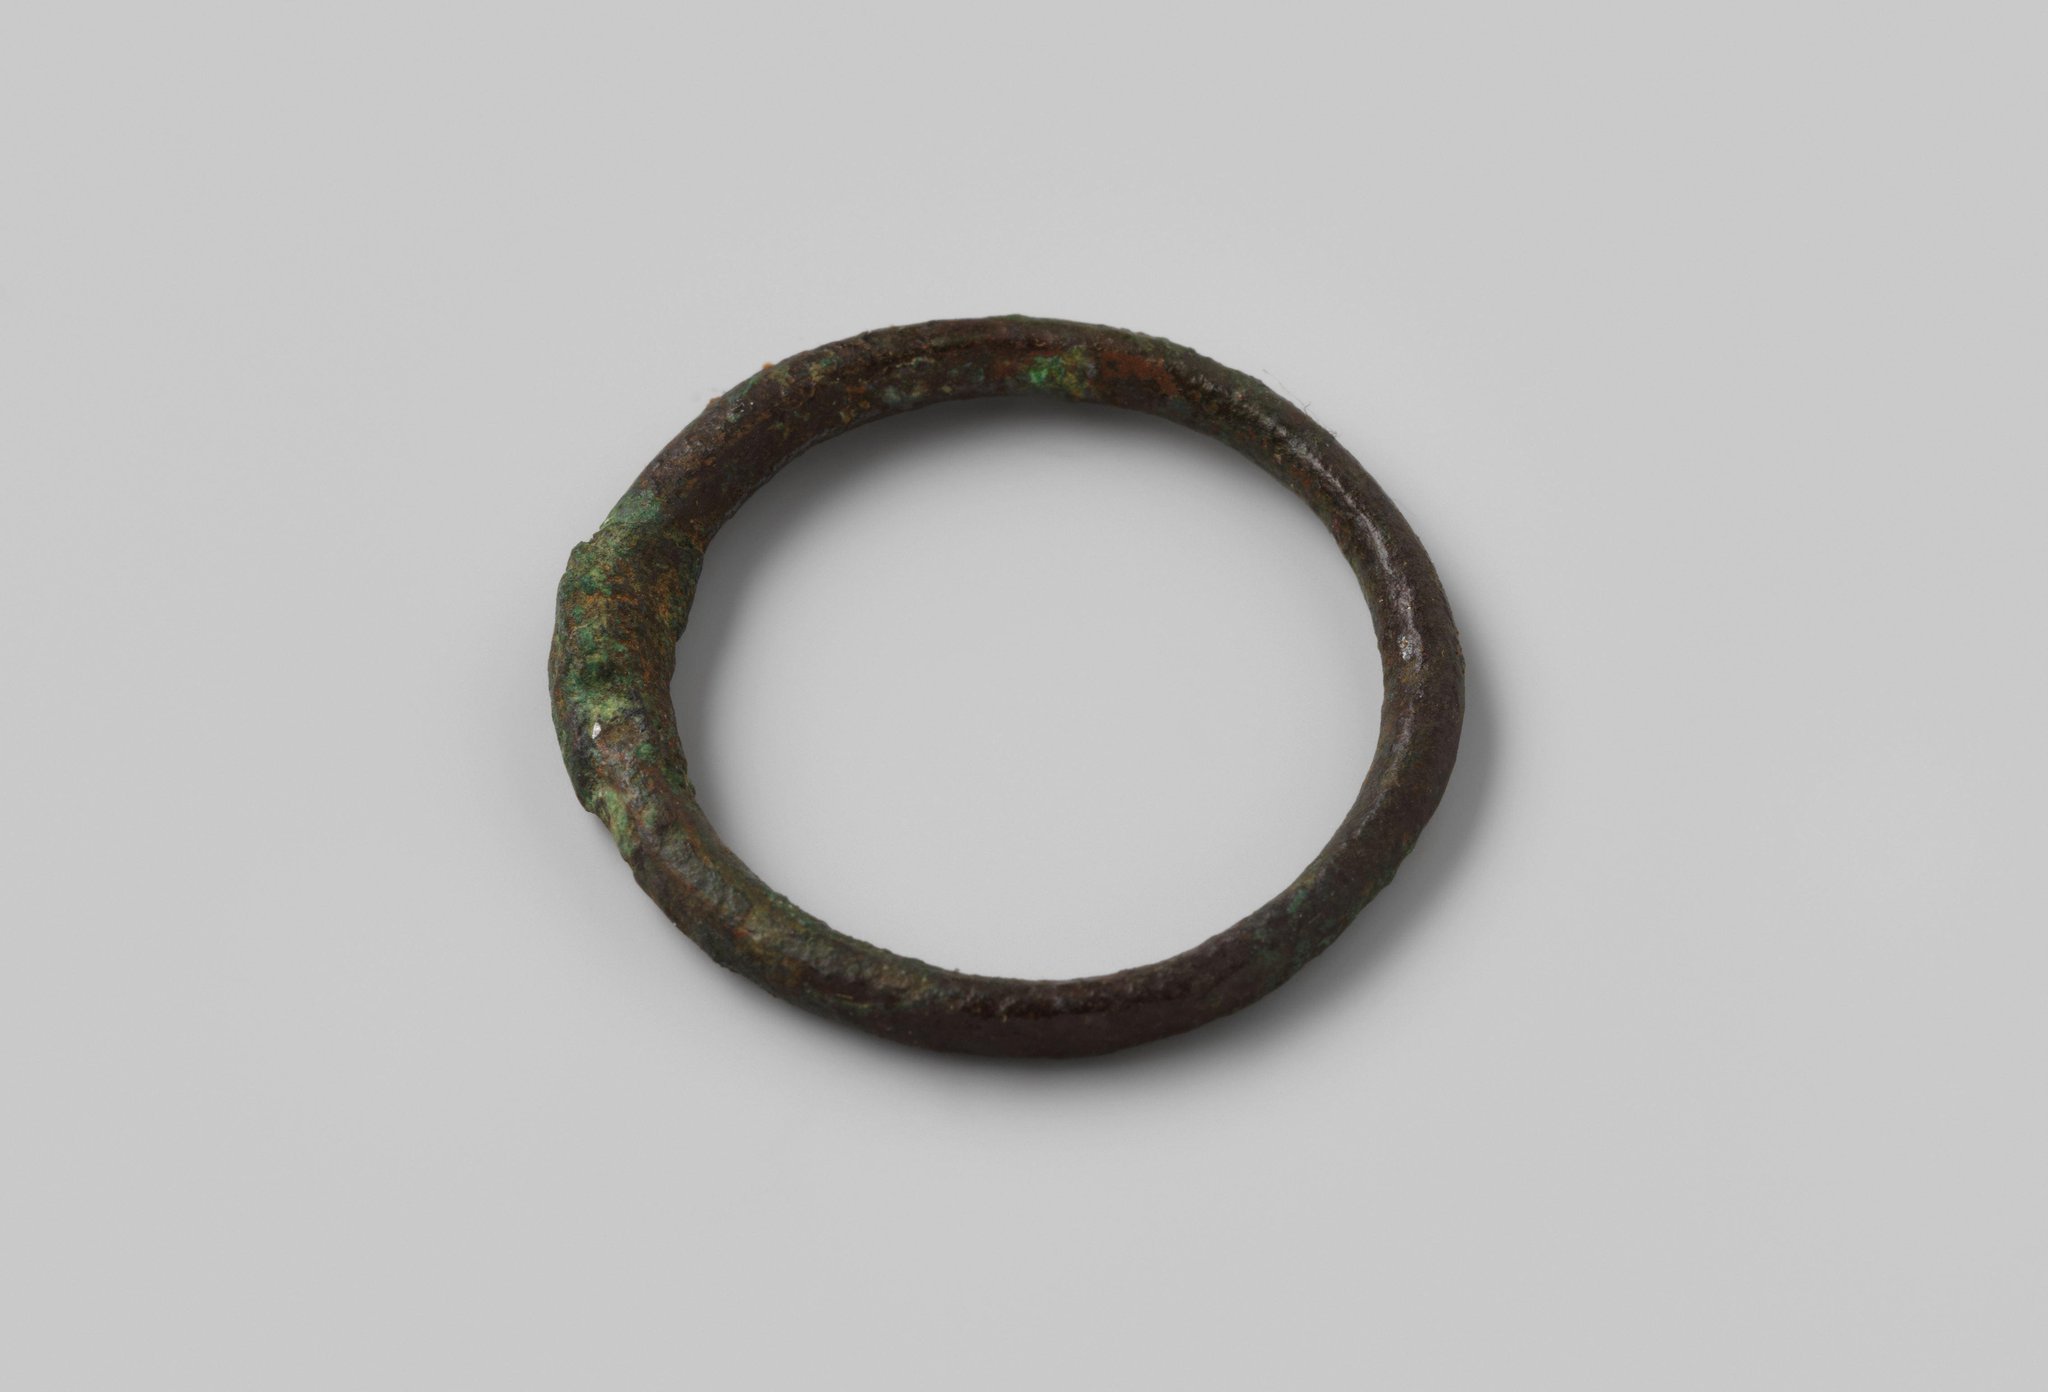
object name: ring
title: Ringvormig fragment uit het wrak van de Oost-Indiëvaarder Hollandia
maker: Anonymous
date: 1700-1743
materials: copper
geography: netherlands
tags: verenigde oostindische compagnie, hollandia (schip), annet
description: Varied parts or fragments, rings or ring-shaped fragments; id. 80H946.